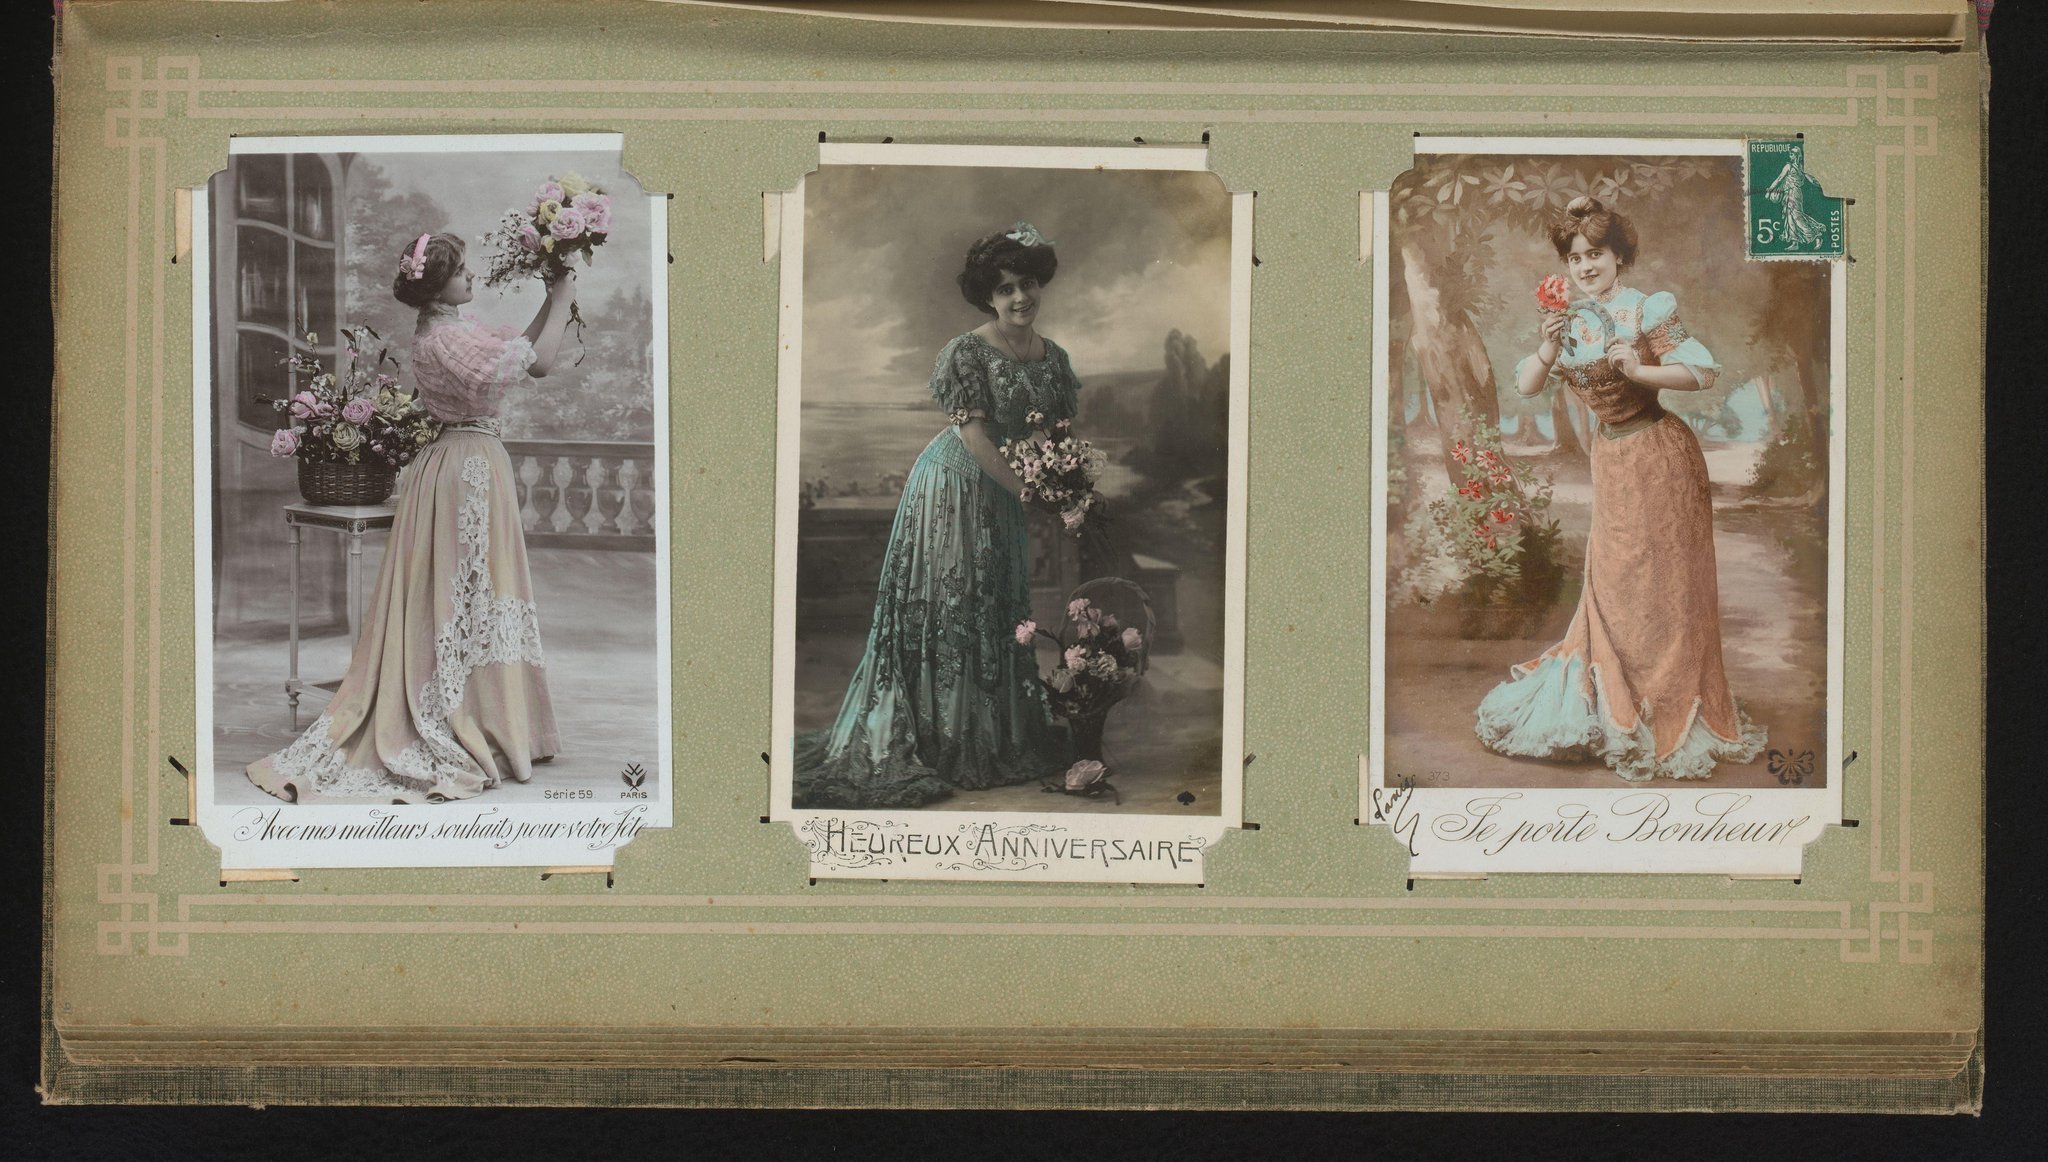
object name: album leaf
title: Drie portretten van vrouwen met bloemen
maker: Anonymous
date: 1900-1930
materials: cardboard, photographic support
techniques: gelatin silver print, hand coloring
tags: flowers, historical persons - bb - woman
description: Deze foto's maken deel uit van een album.